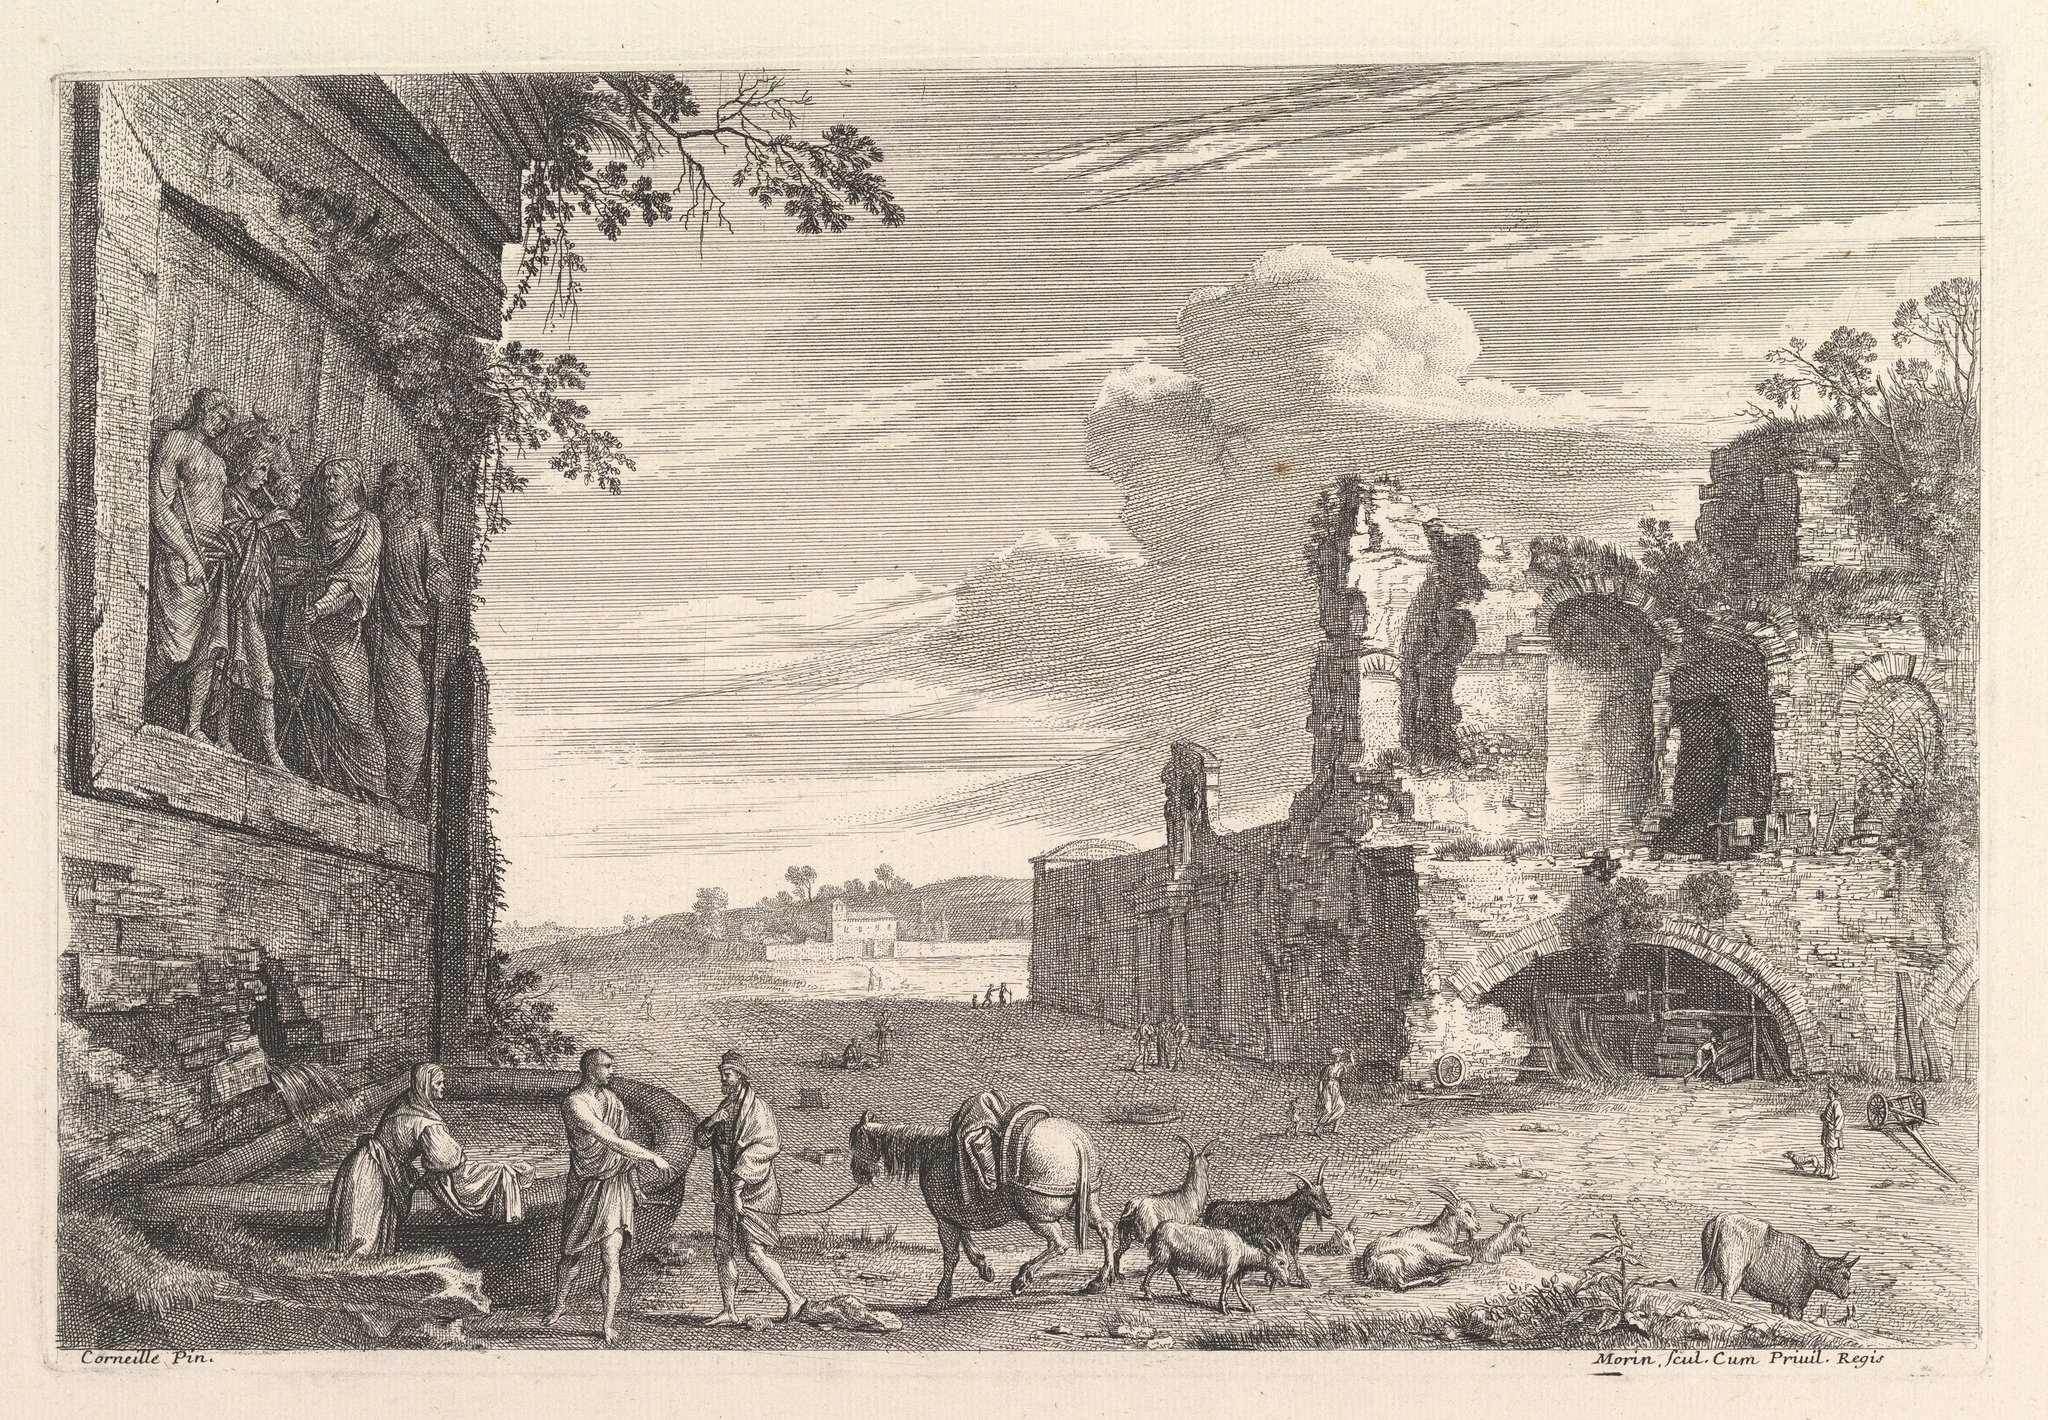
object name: print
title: Les Monuments Romains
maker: jean morin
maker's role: artist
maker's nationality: french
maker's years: 1605-1650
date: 1605-1650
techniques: etching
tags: animals,ruins,men,women